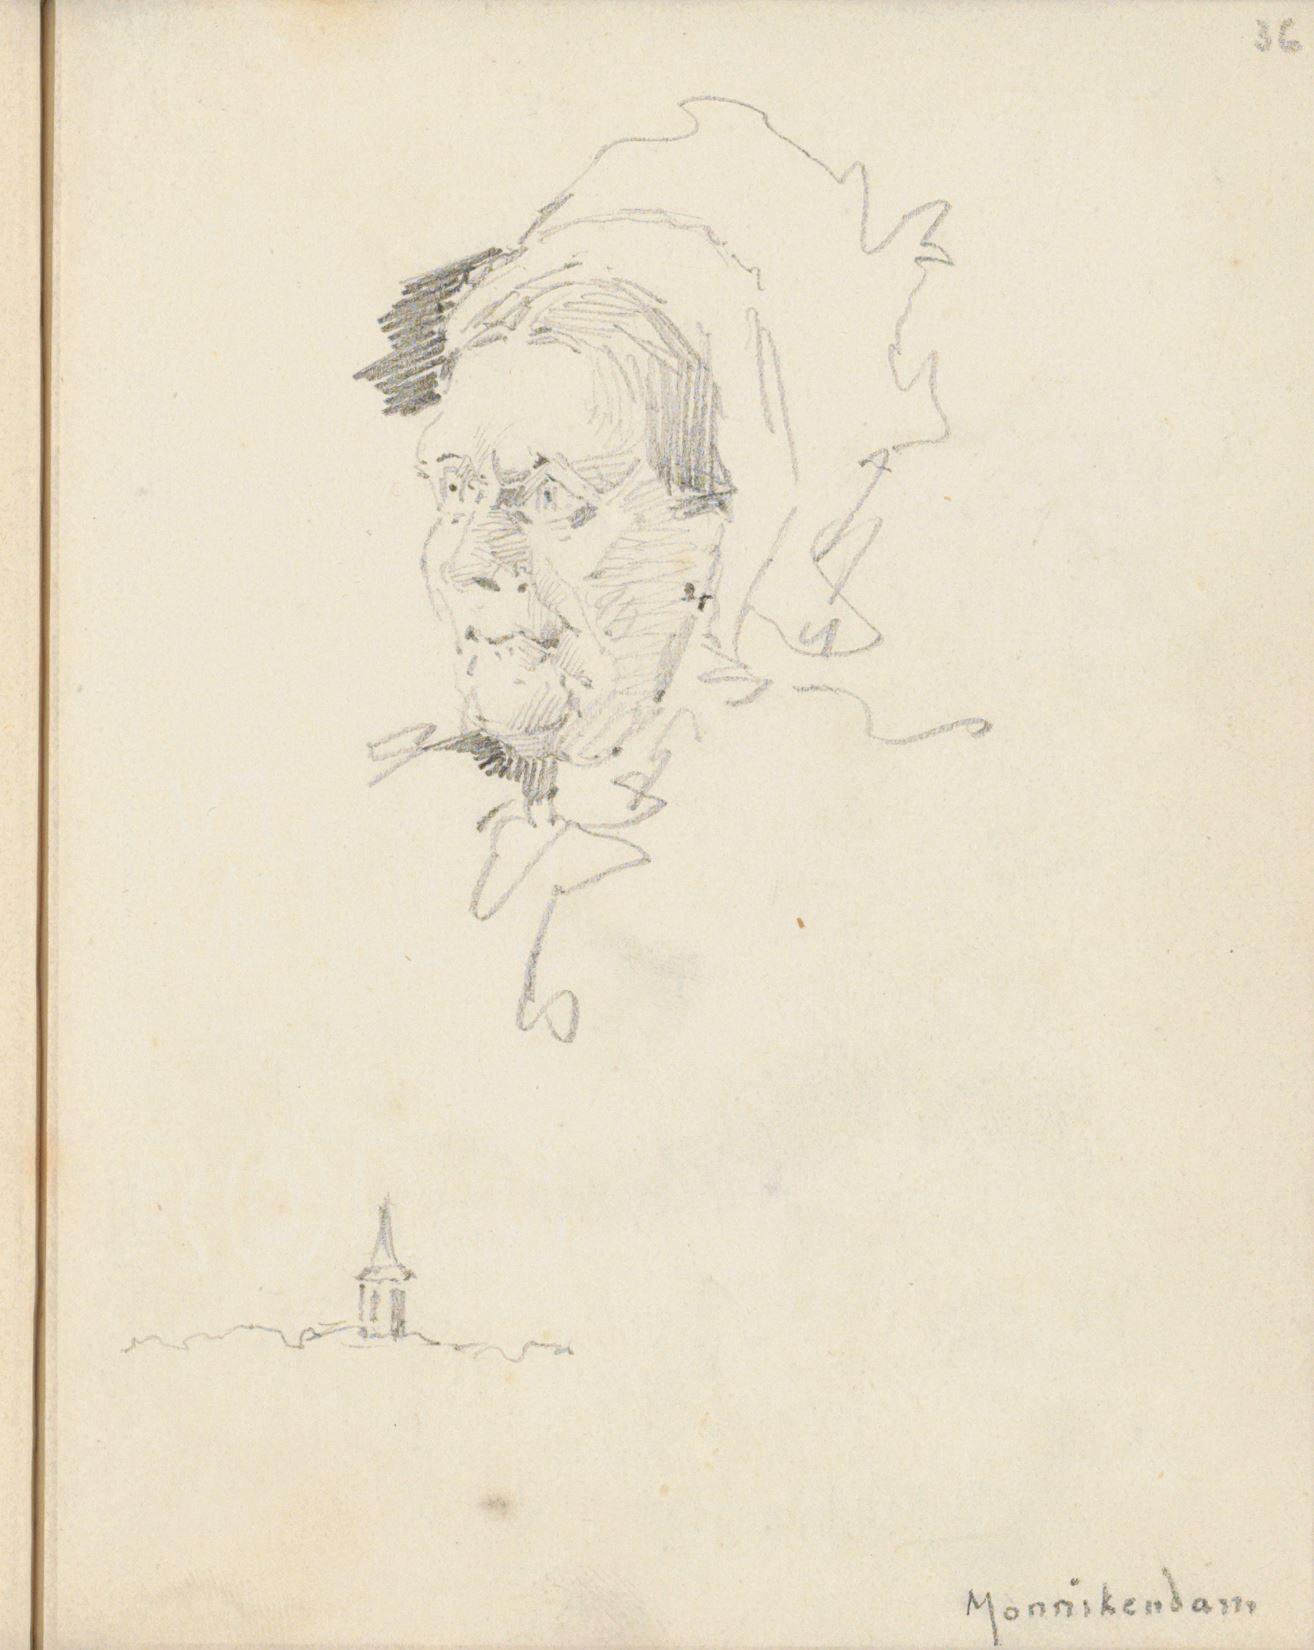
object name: sketchbook leaf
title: Vrouw met een Monnickendammer muts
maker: alfred william rich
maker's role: draughtsman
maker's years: 1856-1921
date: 1892-1893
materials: paper, pencil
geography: monnickendam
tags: folk costume, regional costume (+ women's clothes), parts of church exterior and annexes: tower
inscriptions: annotation: ‘Monnikendam’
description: Tevens een studie van de kerktoren van Monnickendam. Blad 36 recto uit een schetsboek met 86 bladen.